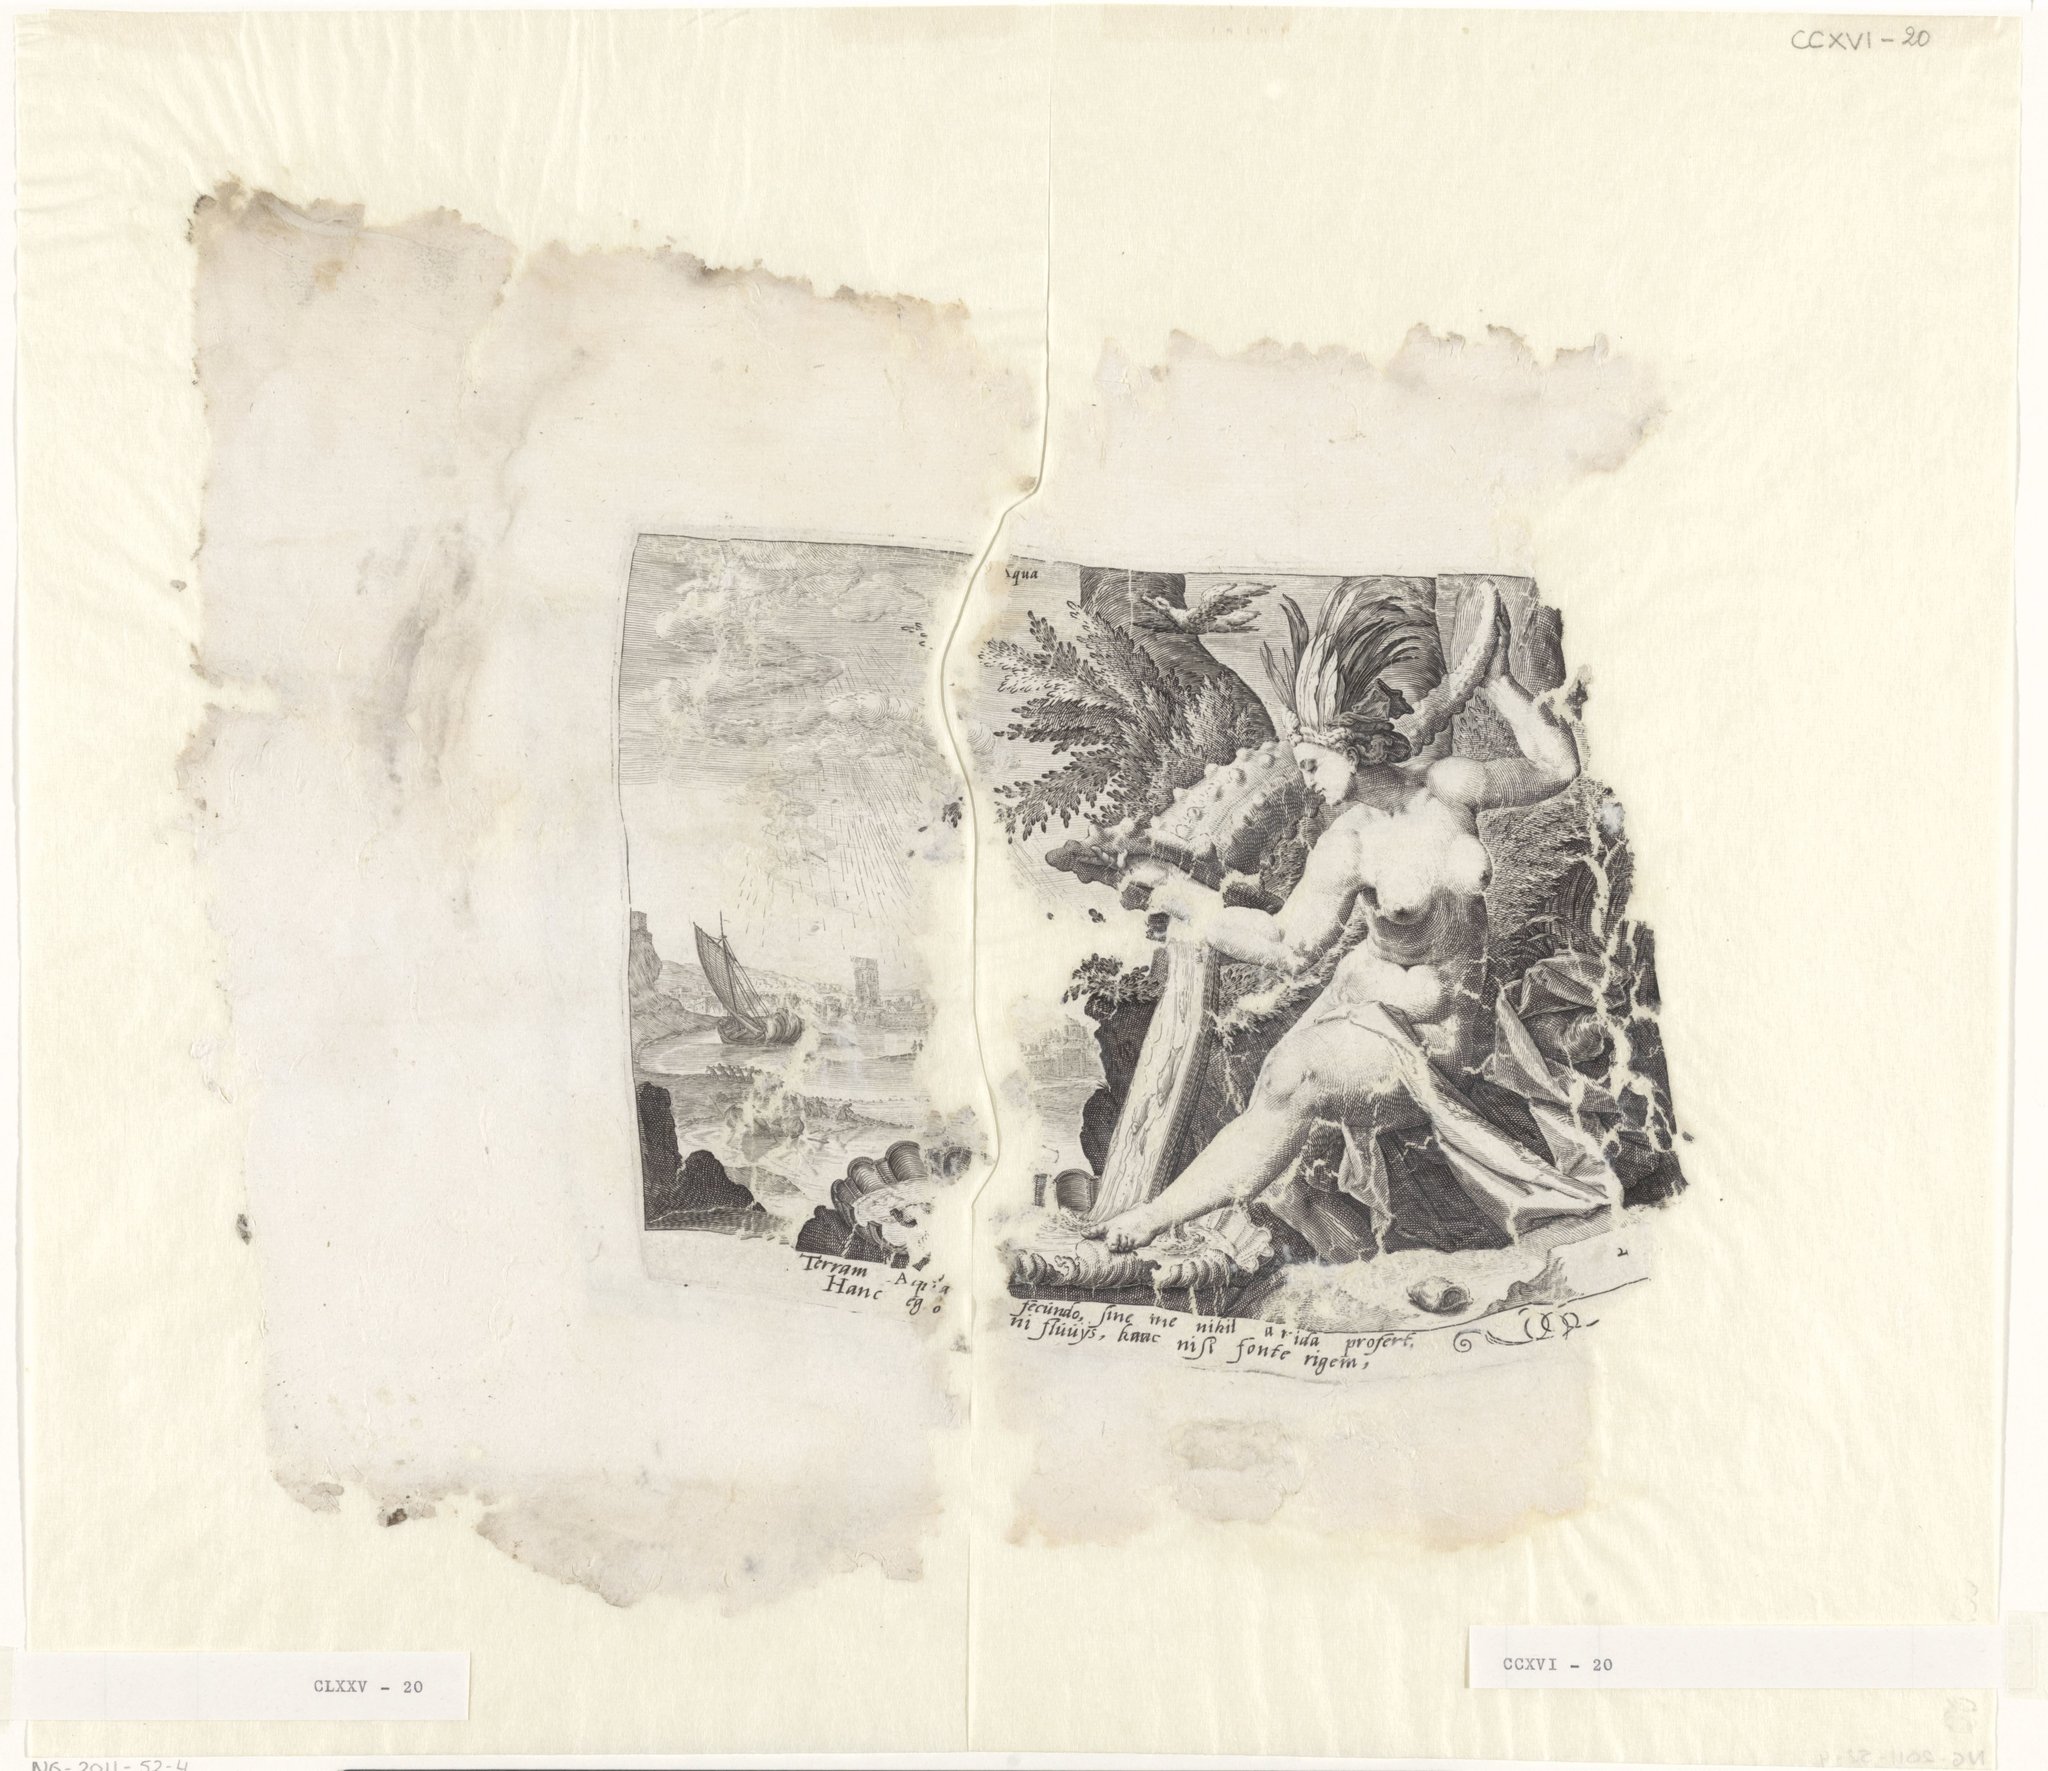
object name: print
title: Aqua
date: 1580-1596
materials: paper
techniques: engraving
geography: amsterdam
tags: water (one of the four elements)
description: De prenten in de Nova Zembla collectie zijn tijdens een expeditie van Willem Barendsz en Jacob van Heemskerk in 1596-1597 noodgedwongen in het winterkamp, het ‘Behouden Huis’, op het eiland achtergelaten. De prenten waren in één of meerdere stapels als handelswaar meegenomen vanuit Amsterdam. Bijna drie eeuwen later, in 1871, keerde de Noor Elling Carlsen terug naar Nova Zembla en vond daar de restanten van het ‘Behouden Huis, inclusief een groot deel van de inventaris. Een deel van de prenten, in de vorm van aaneengekoekte kluiten, werd toen ook teruggevonden. De papierkluiten waren soms op meerdere plekken gebroken. Tussen 1975-1979 zijn de prenten van elkaar gescheiden. Dit leverde in totaal ca. 1000 fragmenten van ca. 400 afdrukken van ca. 150 verschillende prenten op. Voor zover mogelijk zijn de fragmenten samengevoegd en zijn de prenten gereconstrueerd.